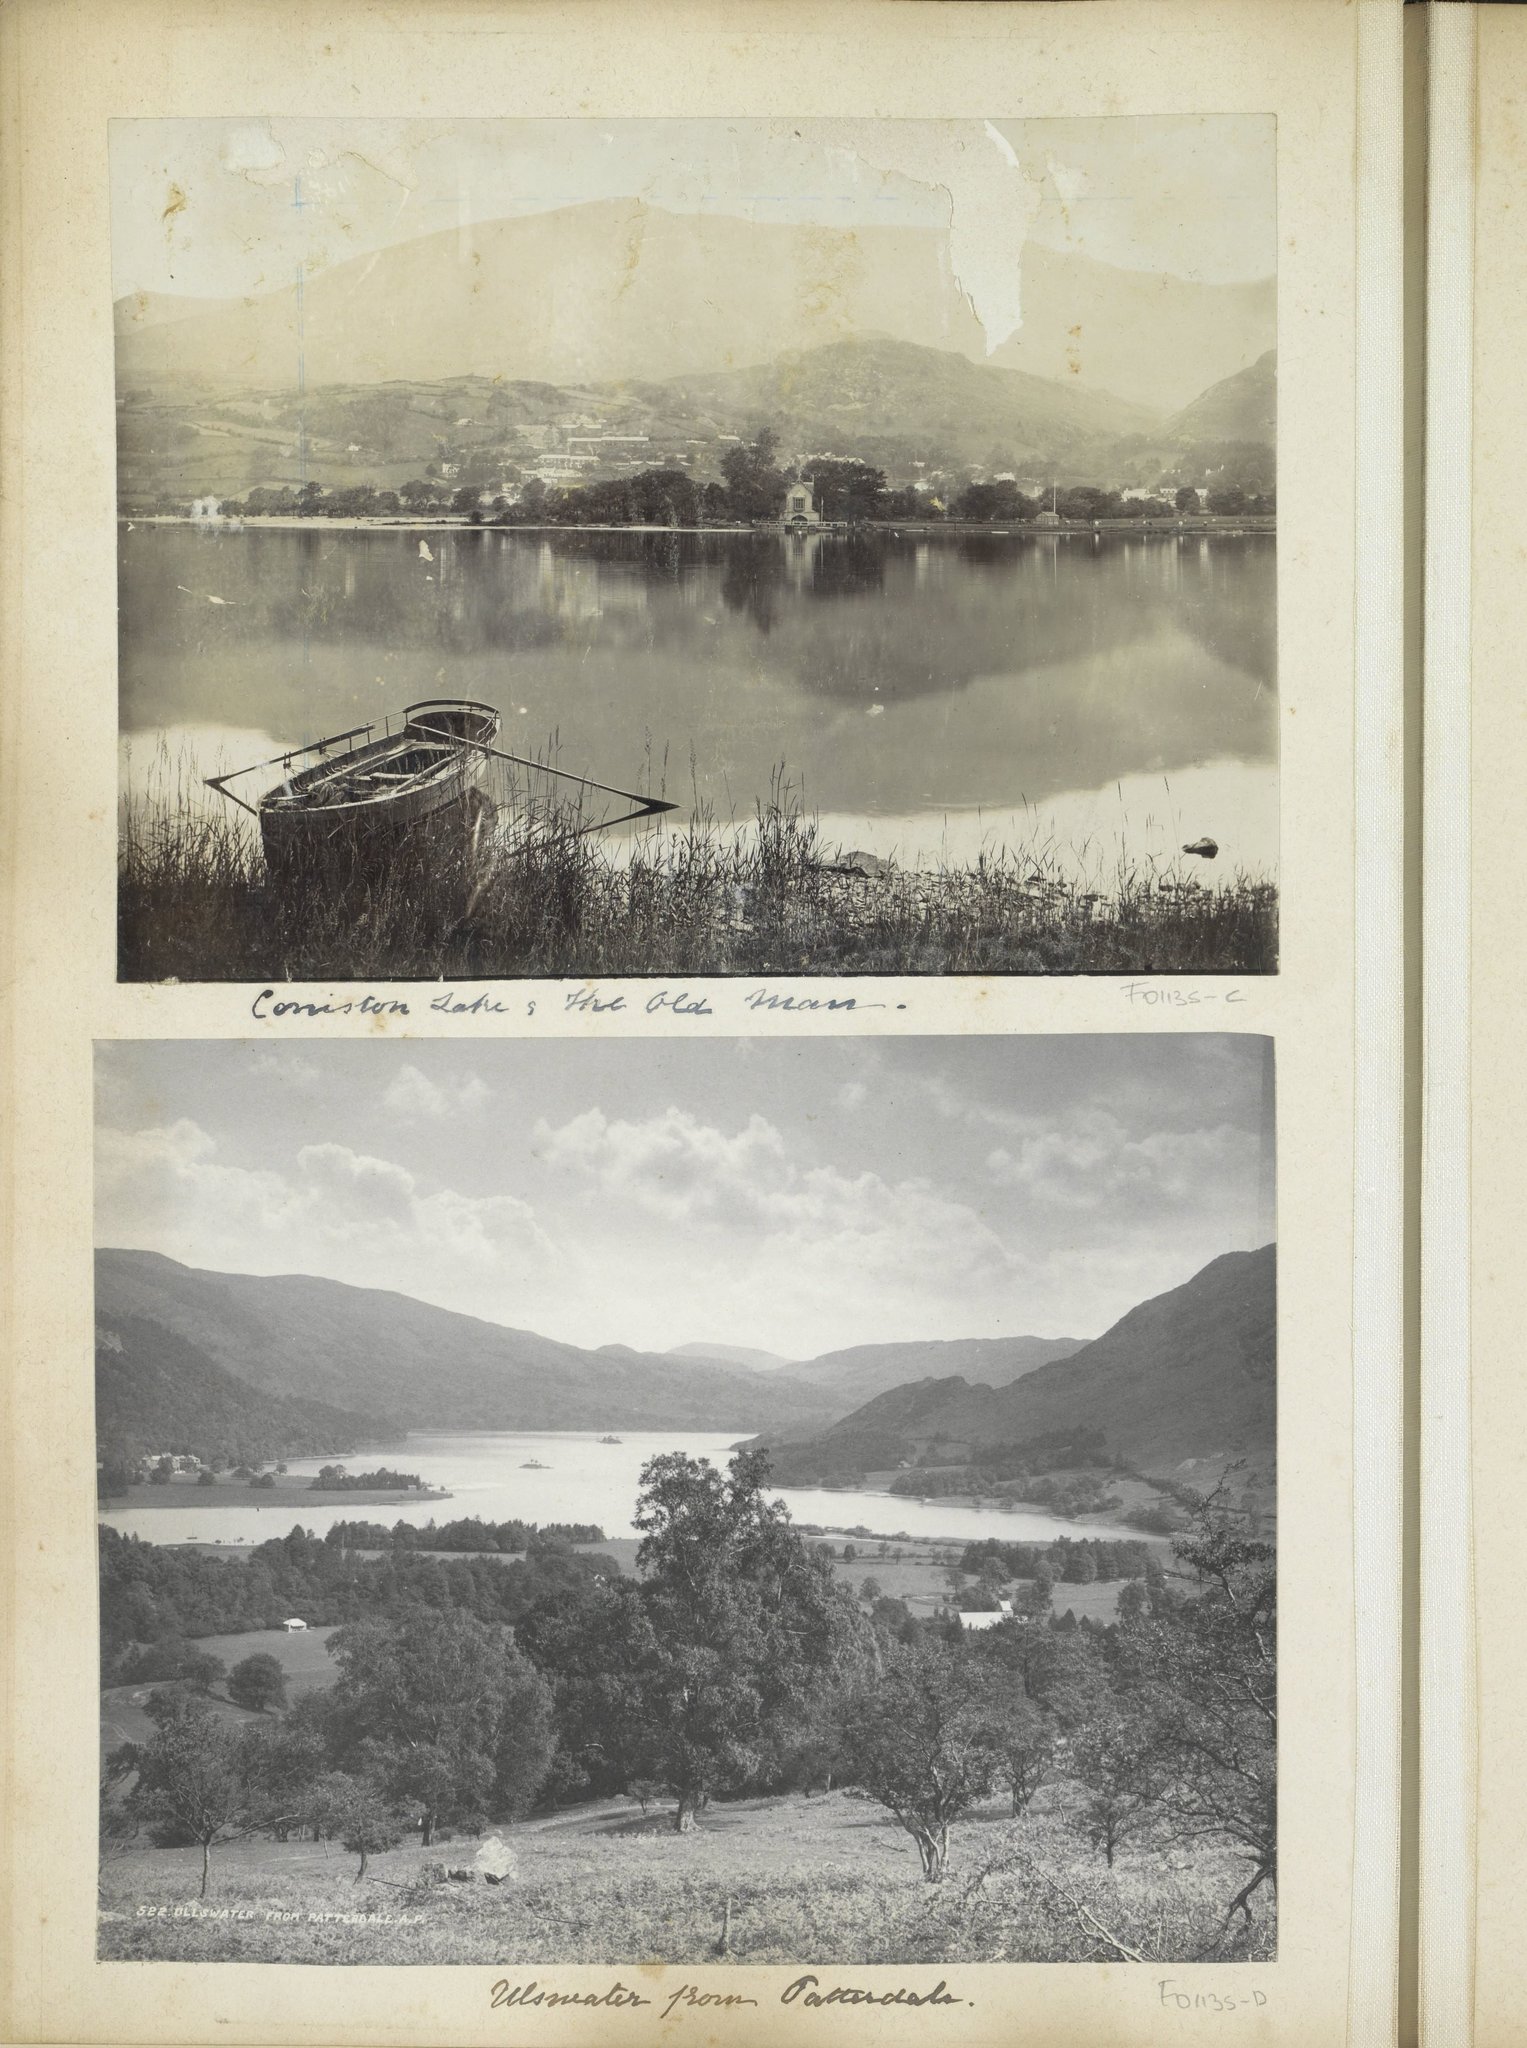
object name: album leaf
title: Gezicht op Coniston Lake en The Old Man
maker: Anonymous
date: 1898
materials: paper, photographic support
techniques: daylight paper print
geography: coniston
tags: (high) hill, lake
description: Onderdeel van Reisalbum met foto's van bezienswaardigheden in Engeland en Frankrijk.